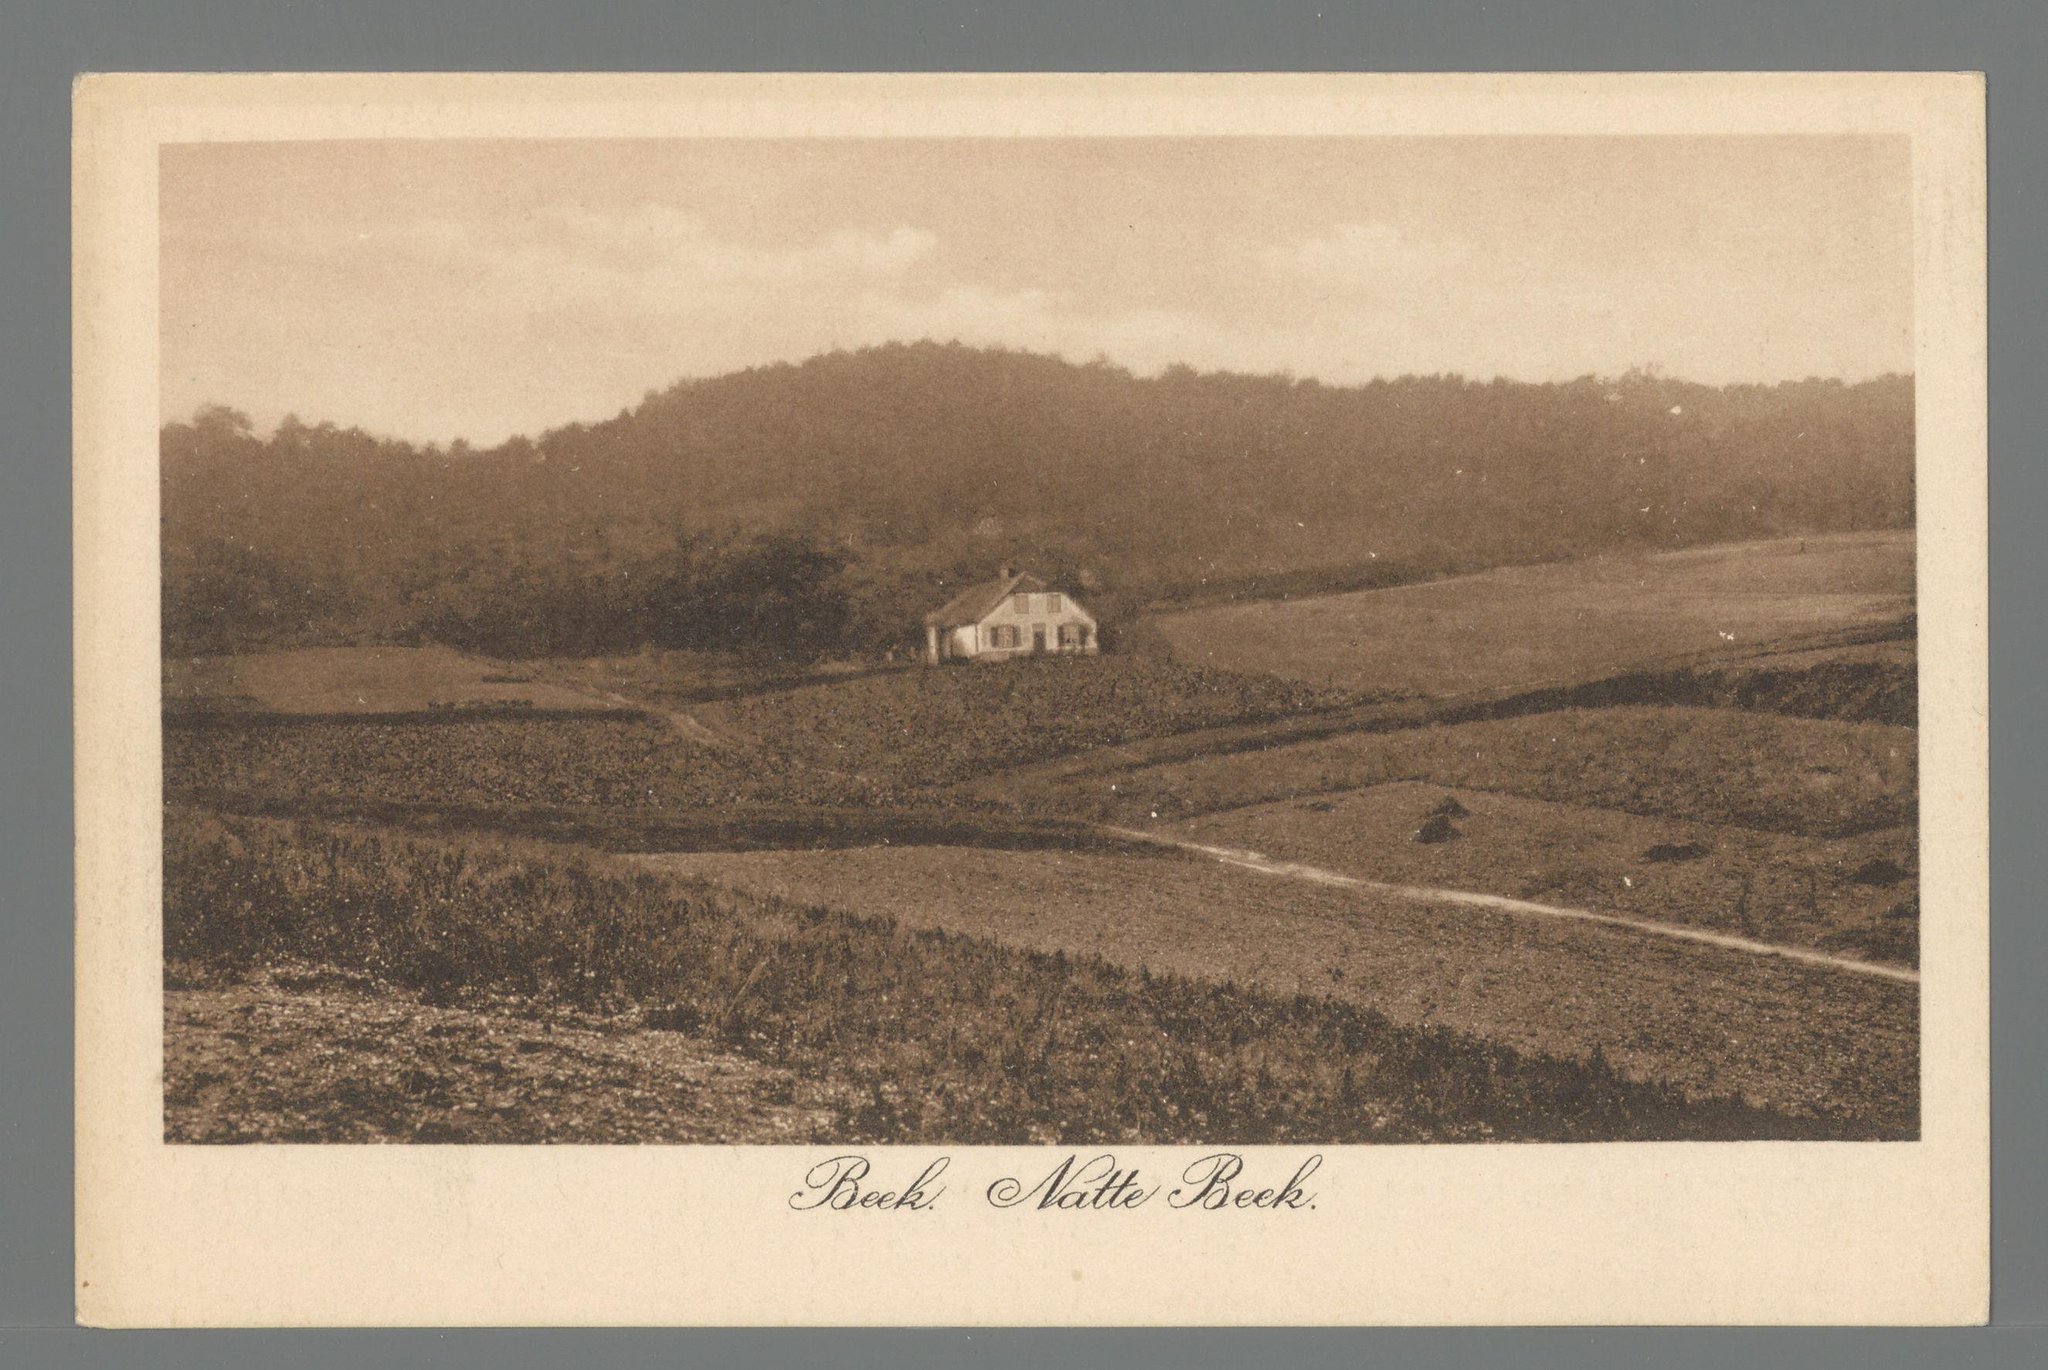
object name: photomechanical print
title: Beek. Natte Beek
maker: Anonymous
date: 1913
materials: cardboard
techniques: photograph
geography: beek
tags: farm or solitary house in landscape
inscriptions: date